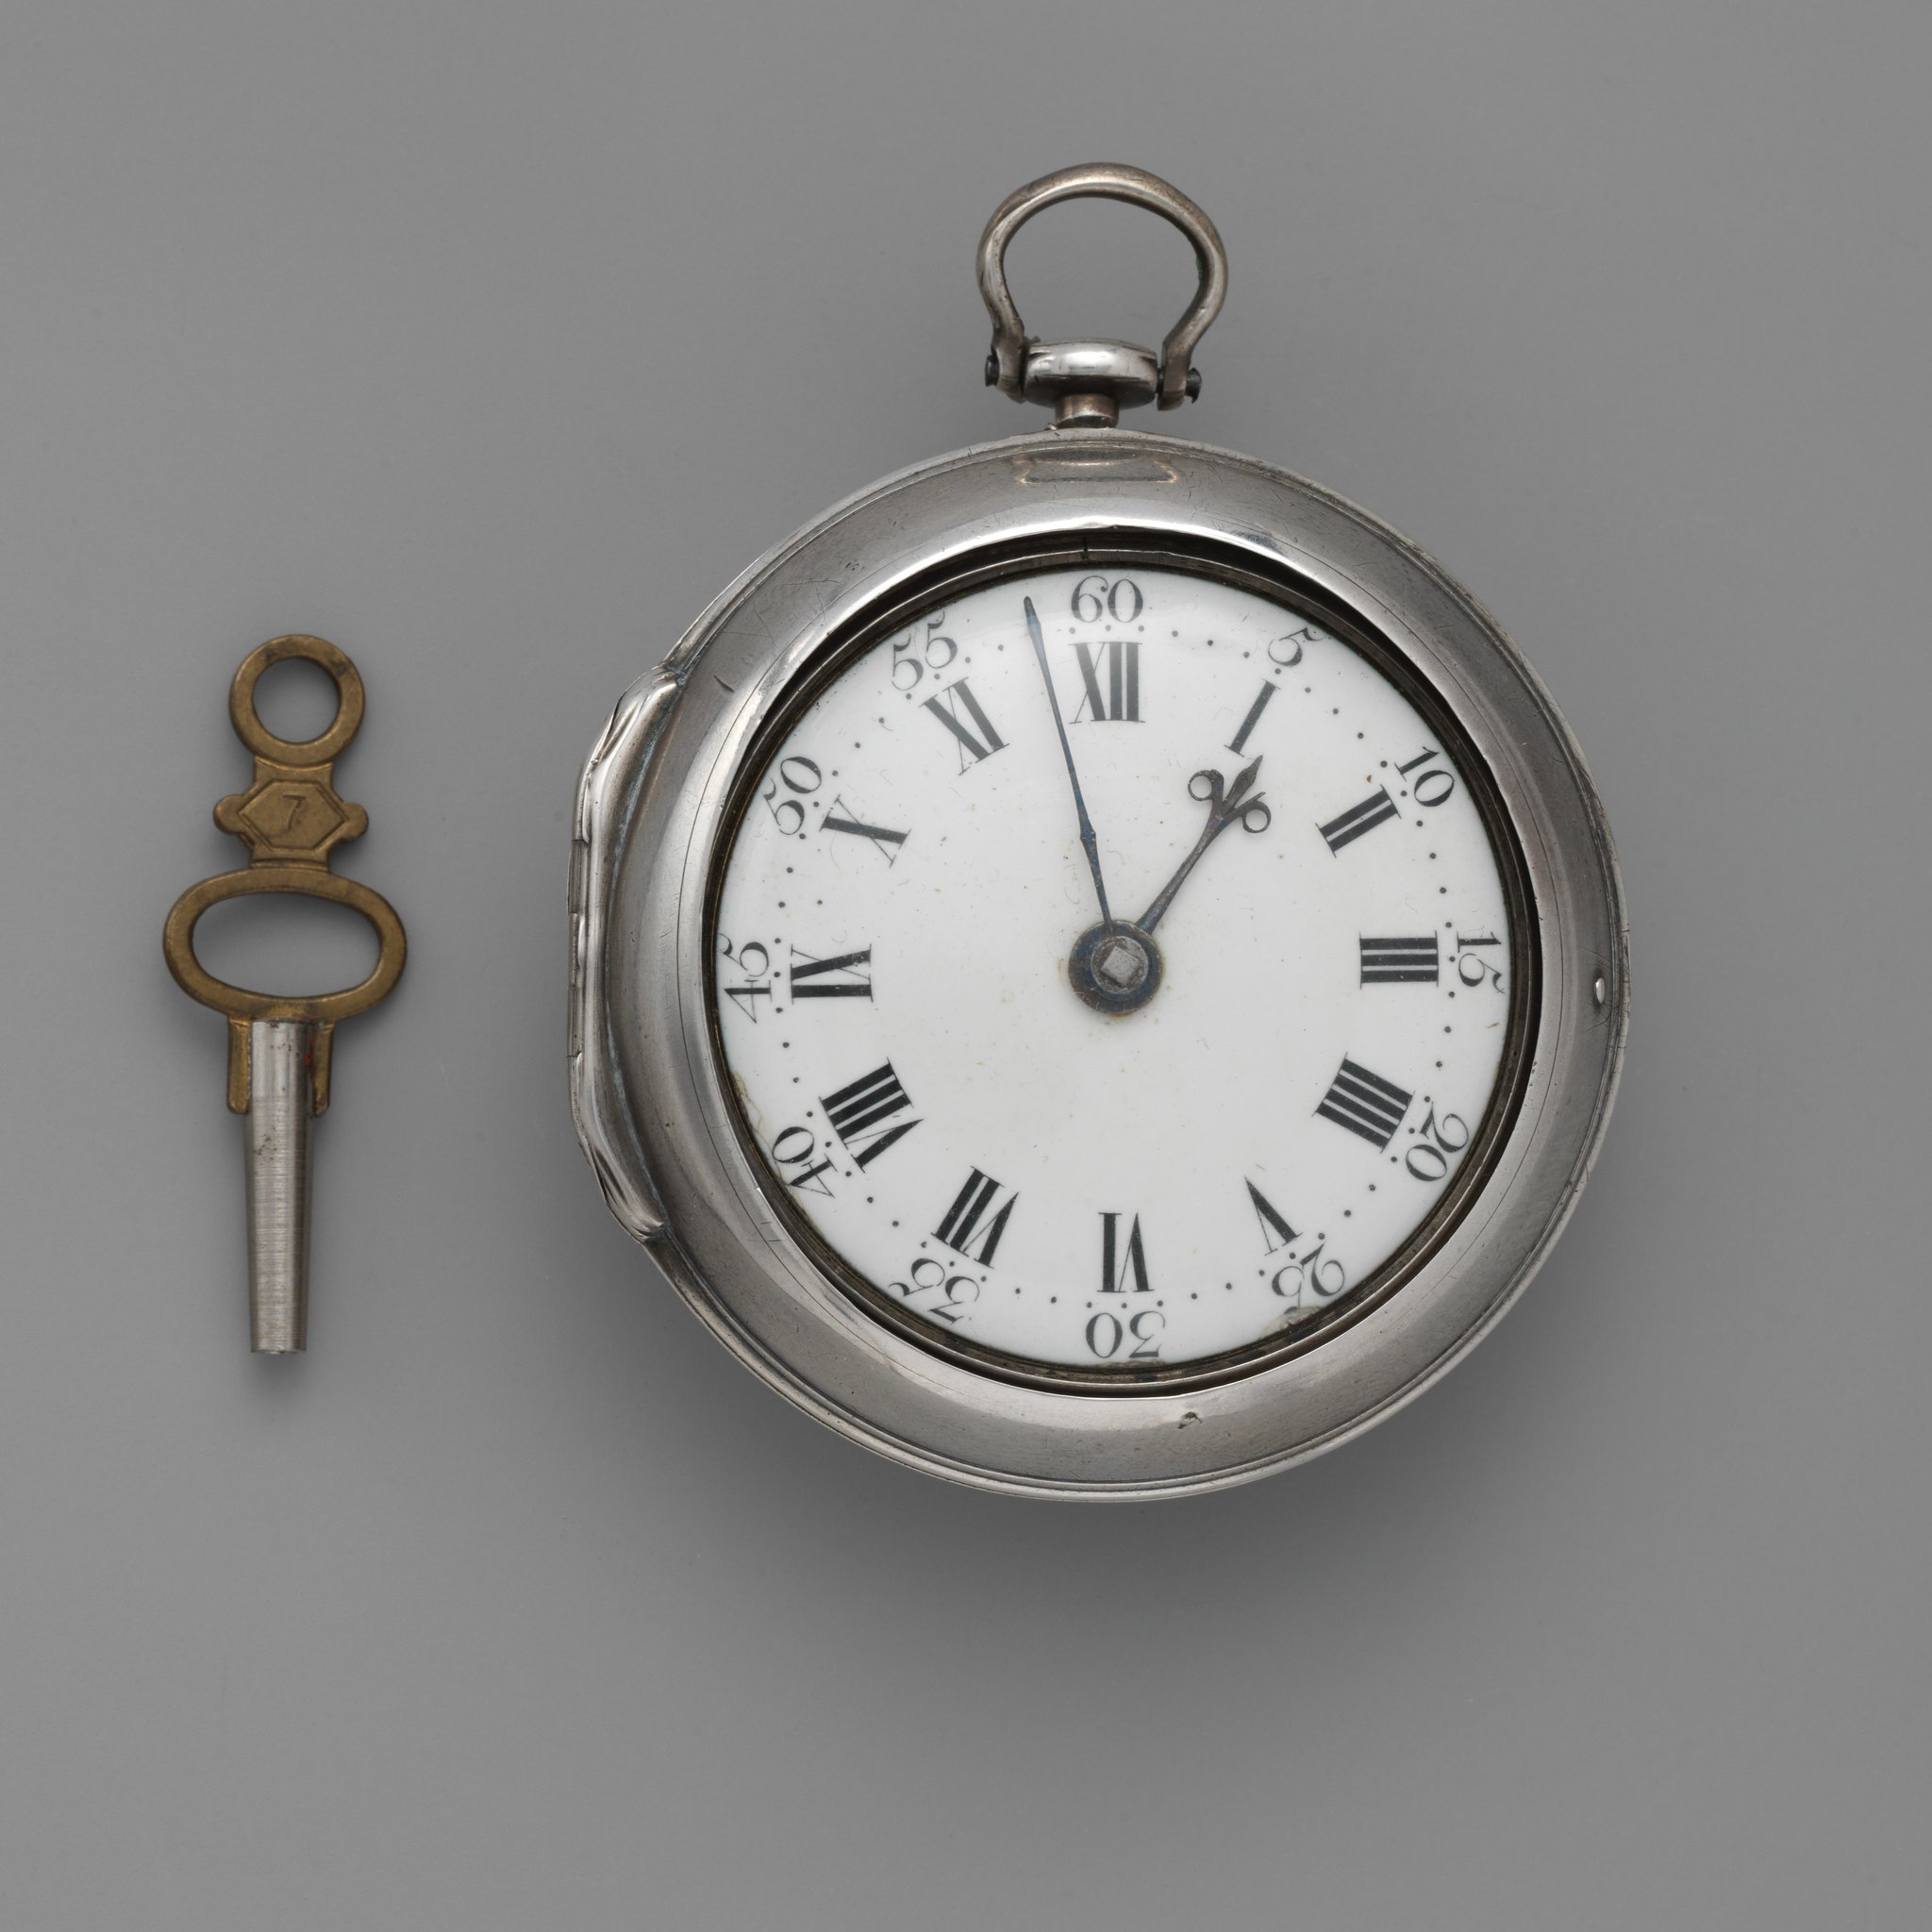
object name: pair case watch and key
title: Pair-case watch and key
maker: stephen gibbs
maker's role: maker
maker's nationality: british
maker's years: 1733-1764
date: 1770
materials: brass, enamel, silver, steel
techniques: painting